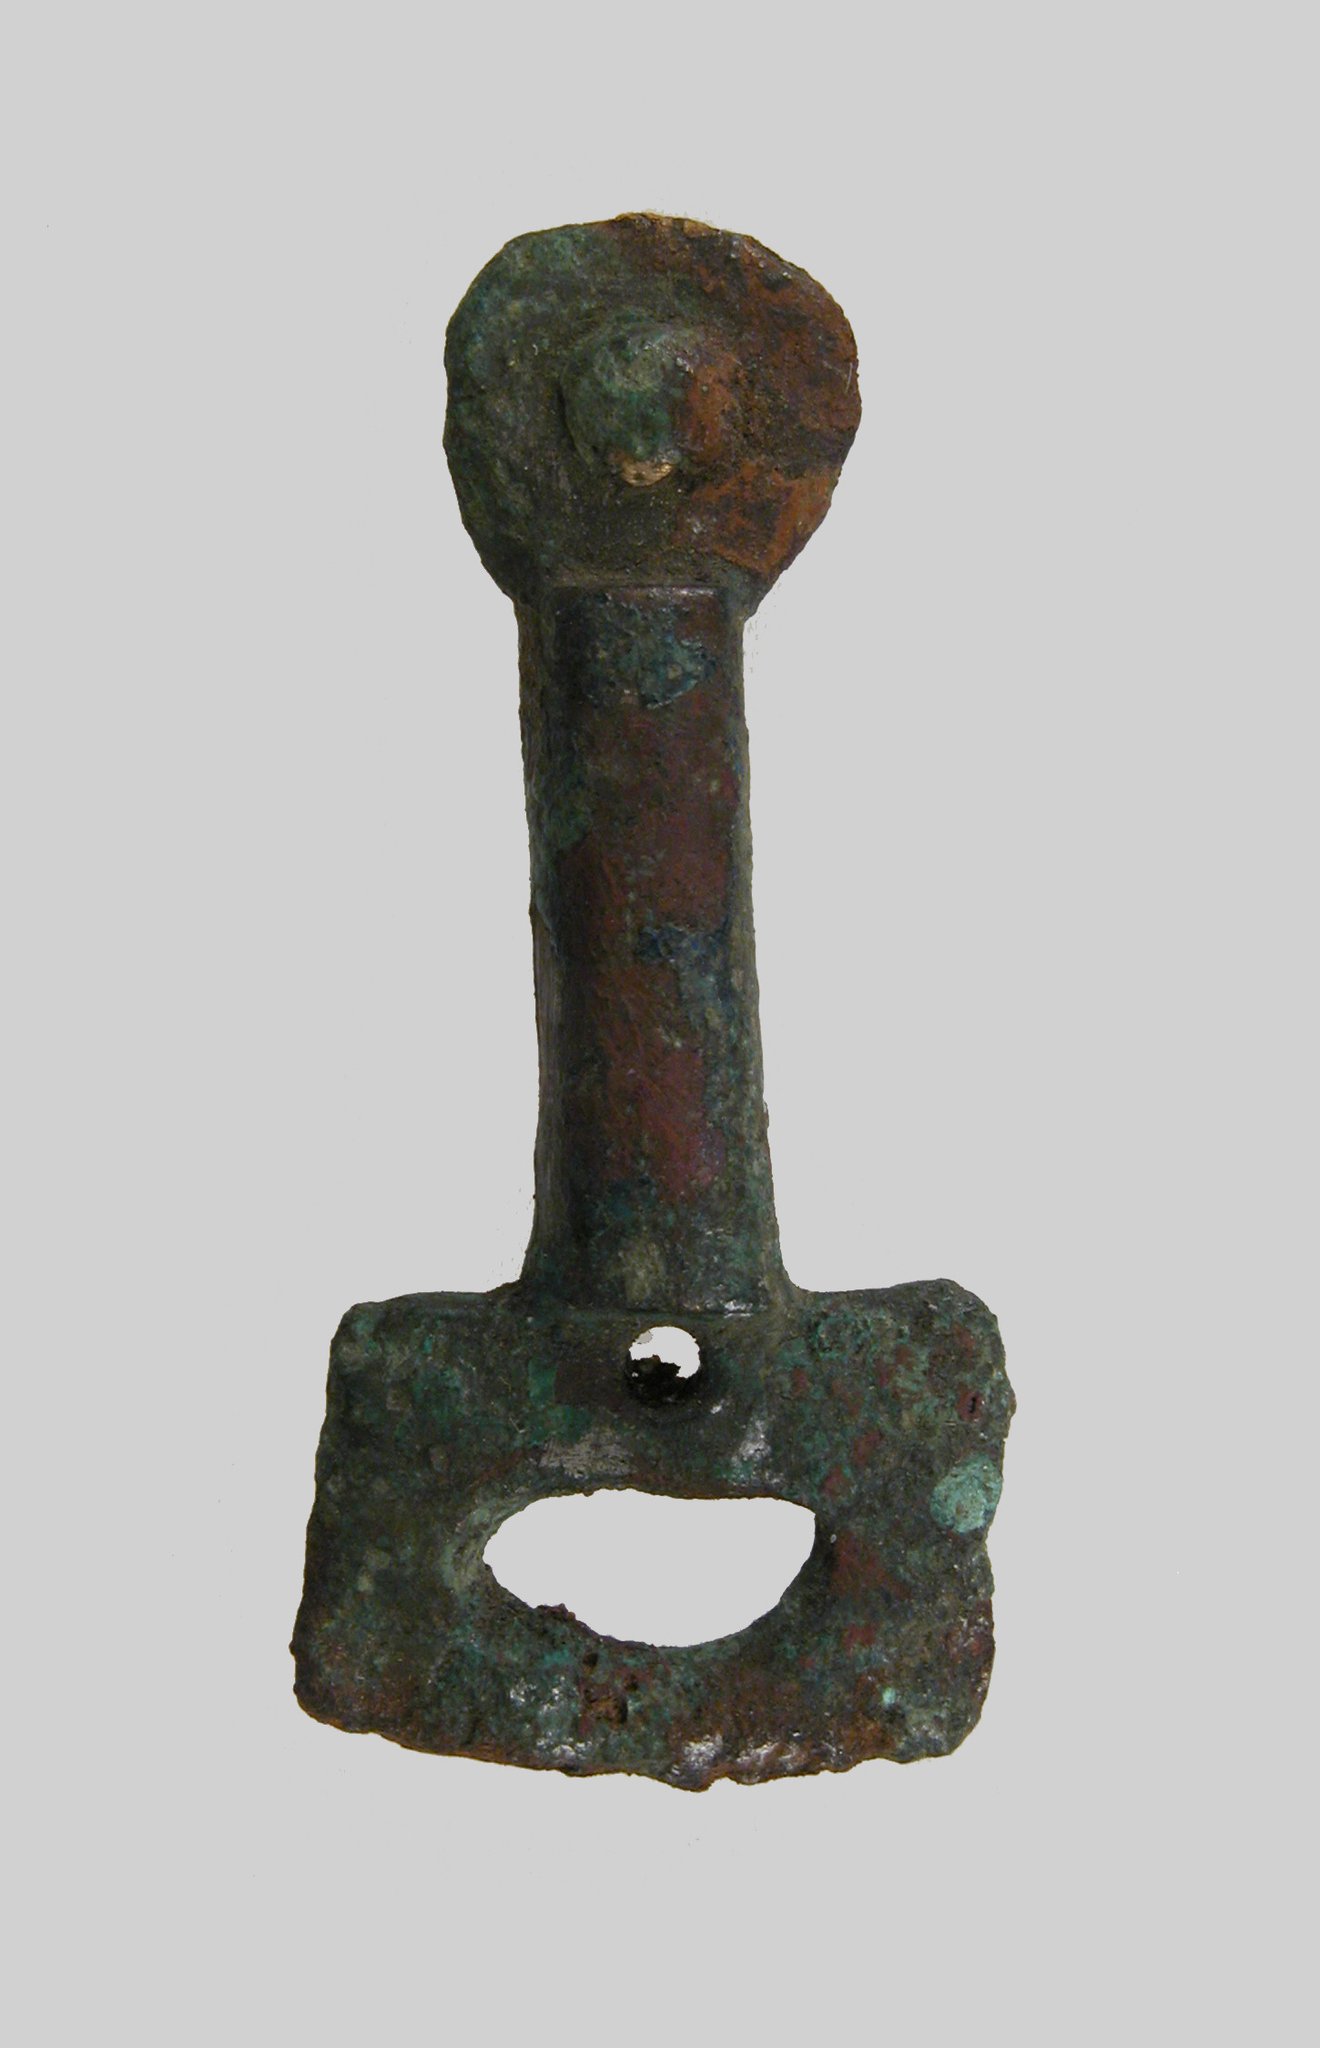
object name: plaque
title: Rectangular Plaque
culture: frankish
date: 534-566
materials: copper alloy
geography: germany